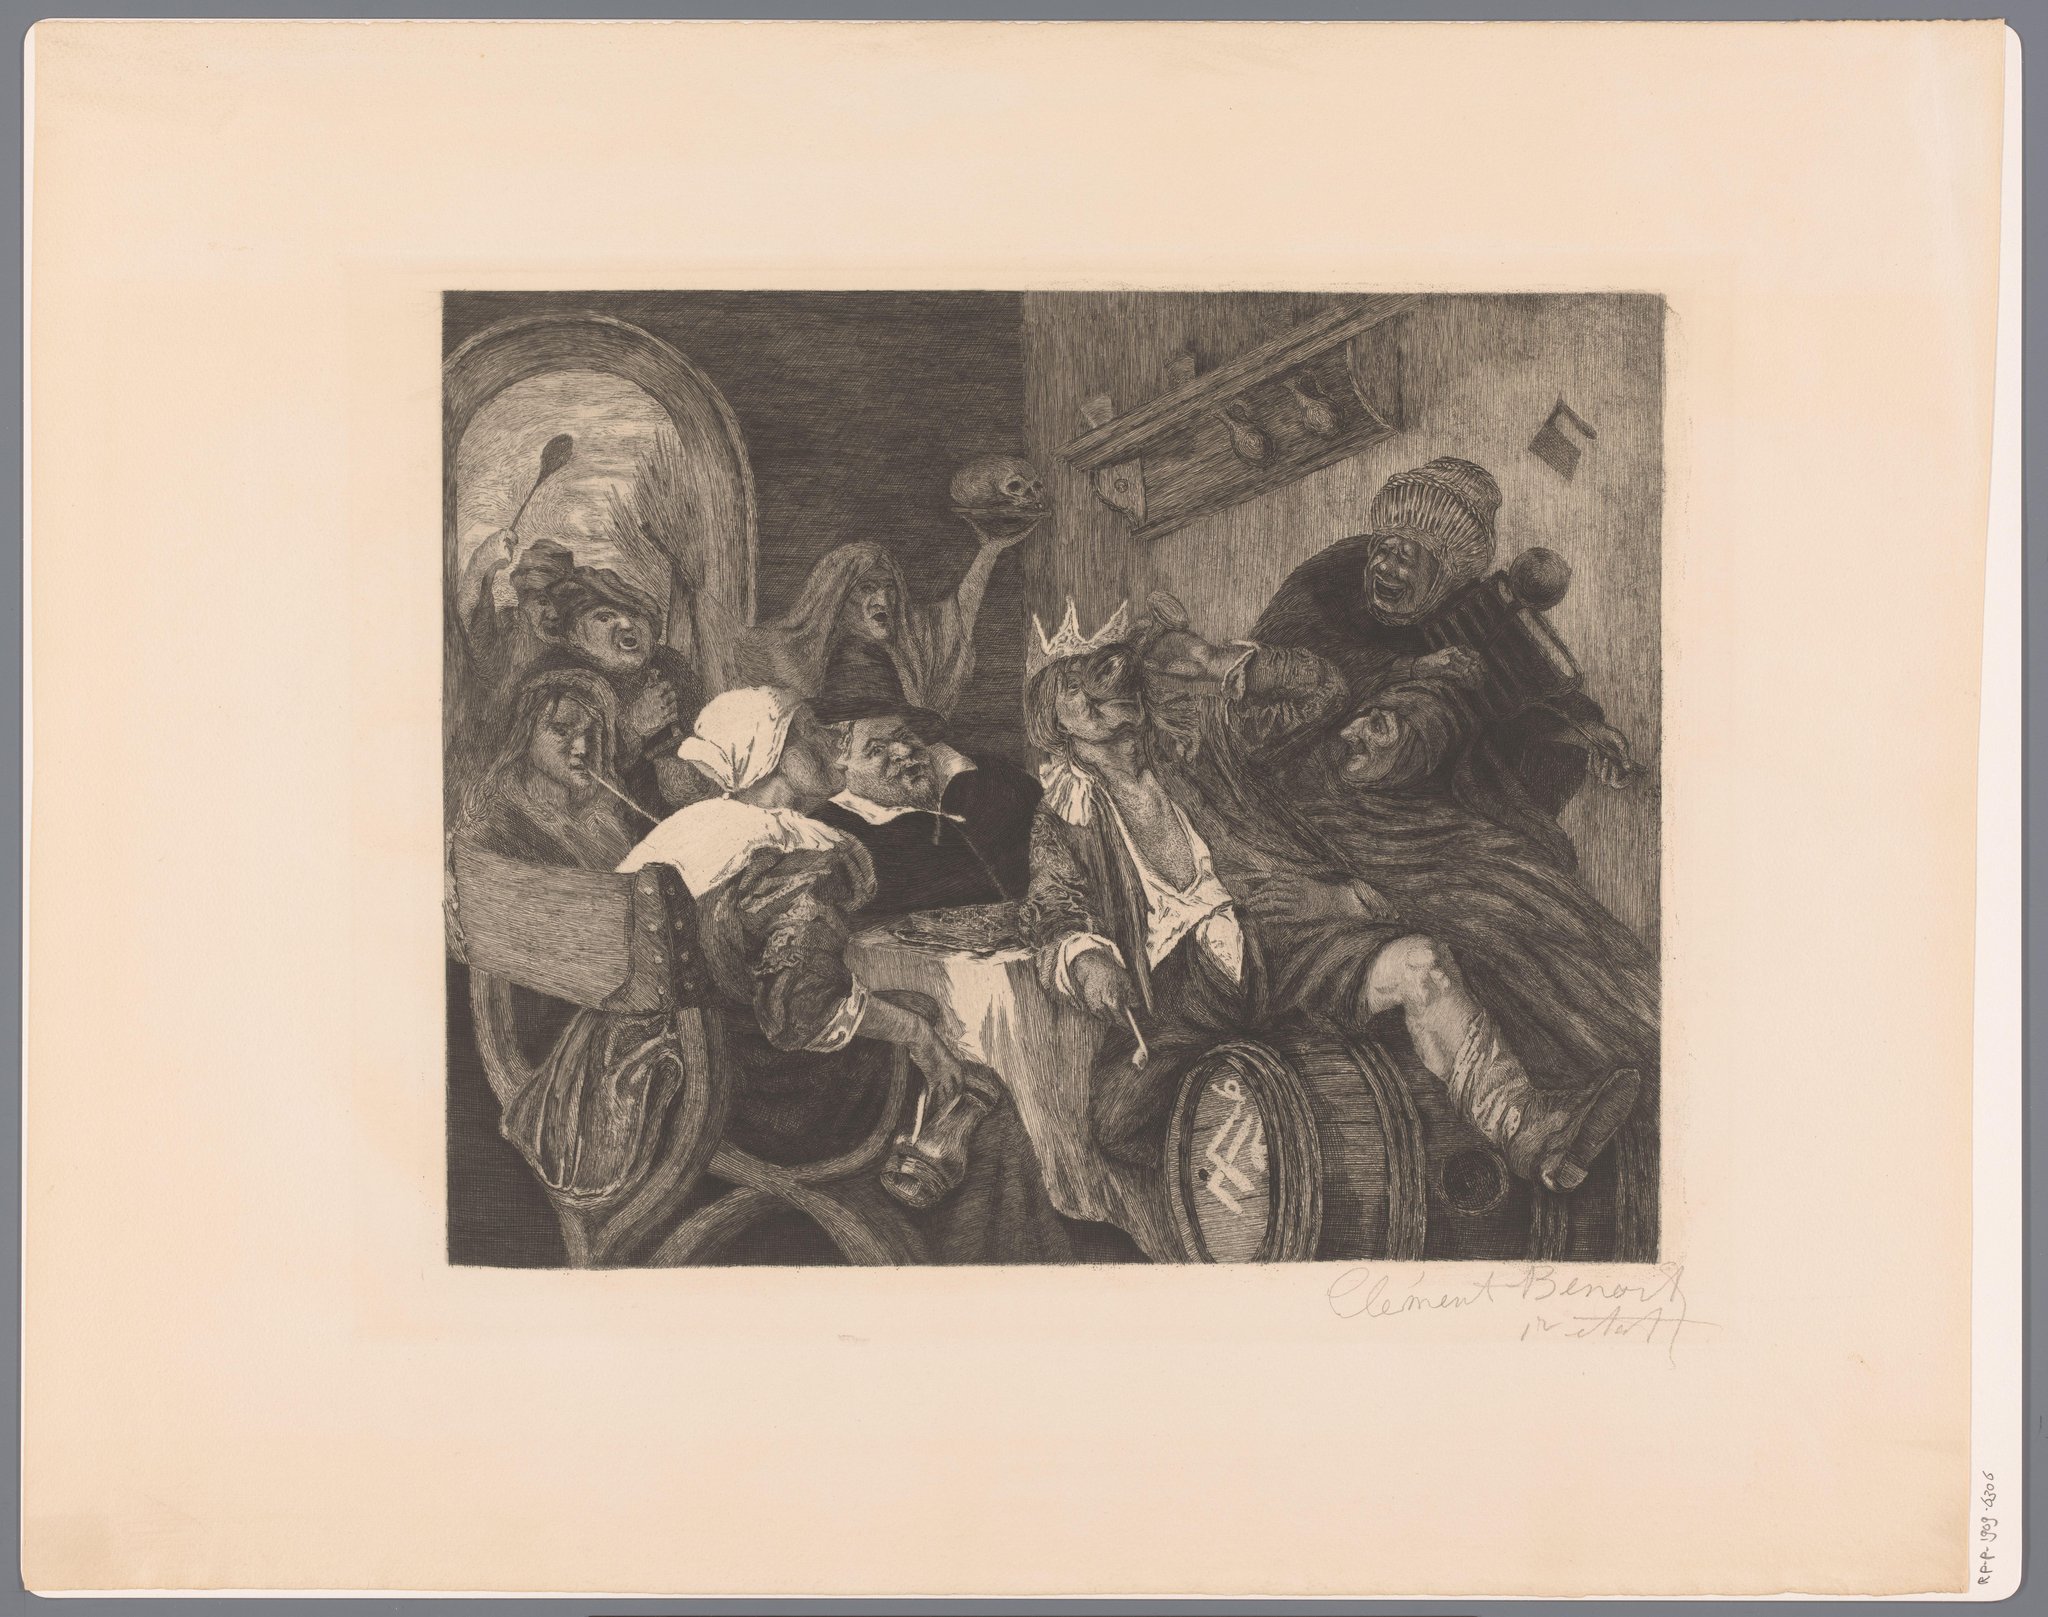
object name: print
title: Driekoningenfeest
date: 1894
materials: paper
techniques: etching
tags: feasts of saints (and their relics), periodic celebrations, popular feasts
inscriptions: collector's mark: Lugt 2228